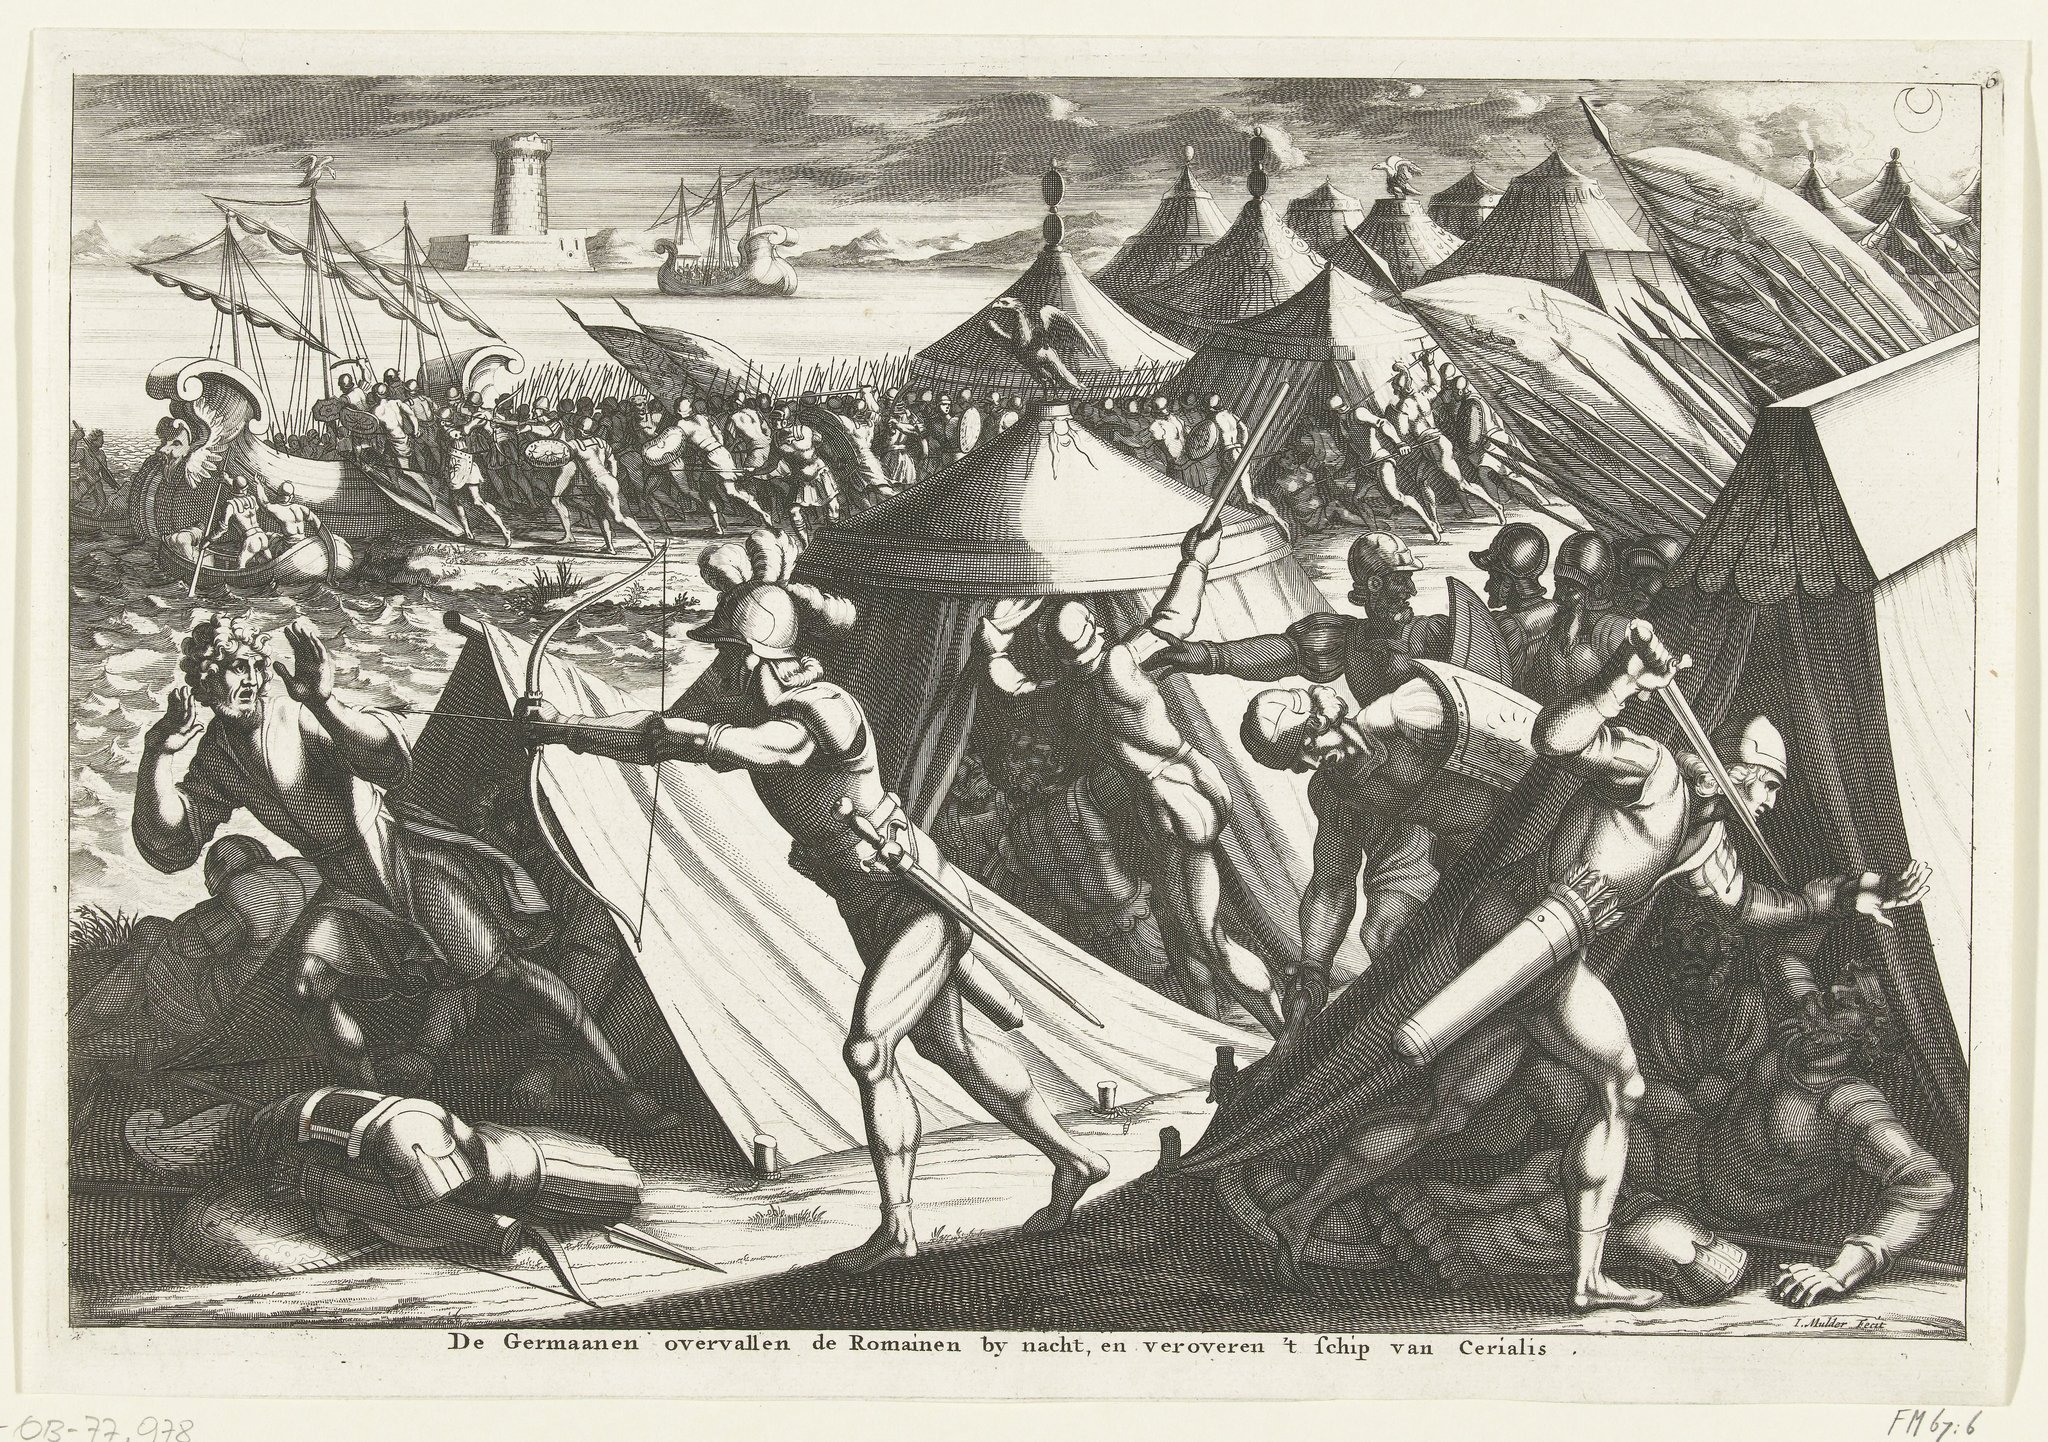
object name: print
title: Nachtelijk overval op het legerkamp van Cerialis waarbij zijn schip wordt buitgemaakt, 69-70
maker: joseph mulder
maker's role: print maker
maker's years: 1658-1718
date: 1682-1684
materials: paper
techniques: etching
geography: northern netherlands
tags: battle, fighting in general, extinct, 'historical' peoples (with name), netherlands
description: Nachtelijk overval op het legerkamp van Cerialis waarbij zijn vlaggenschip wordt buitgemaakt. Onderdeel van een serie van zes prenten over de Bataafse Opstand, gekopieerd naar de reeks Batavorum cum Romanis bellum van Antonio Tempesta (Otto Vaenius, Antwerpen 1612).